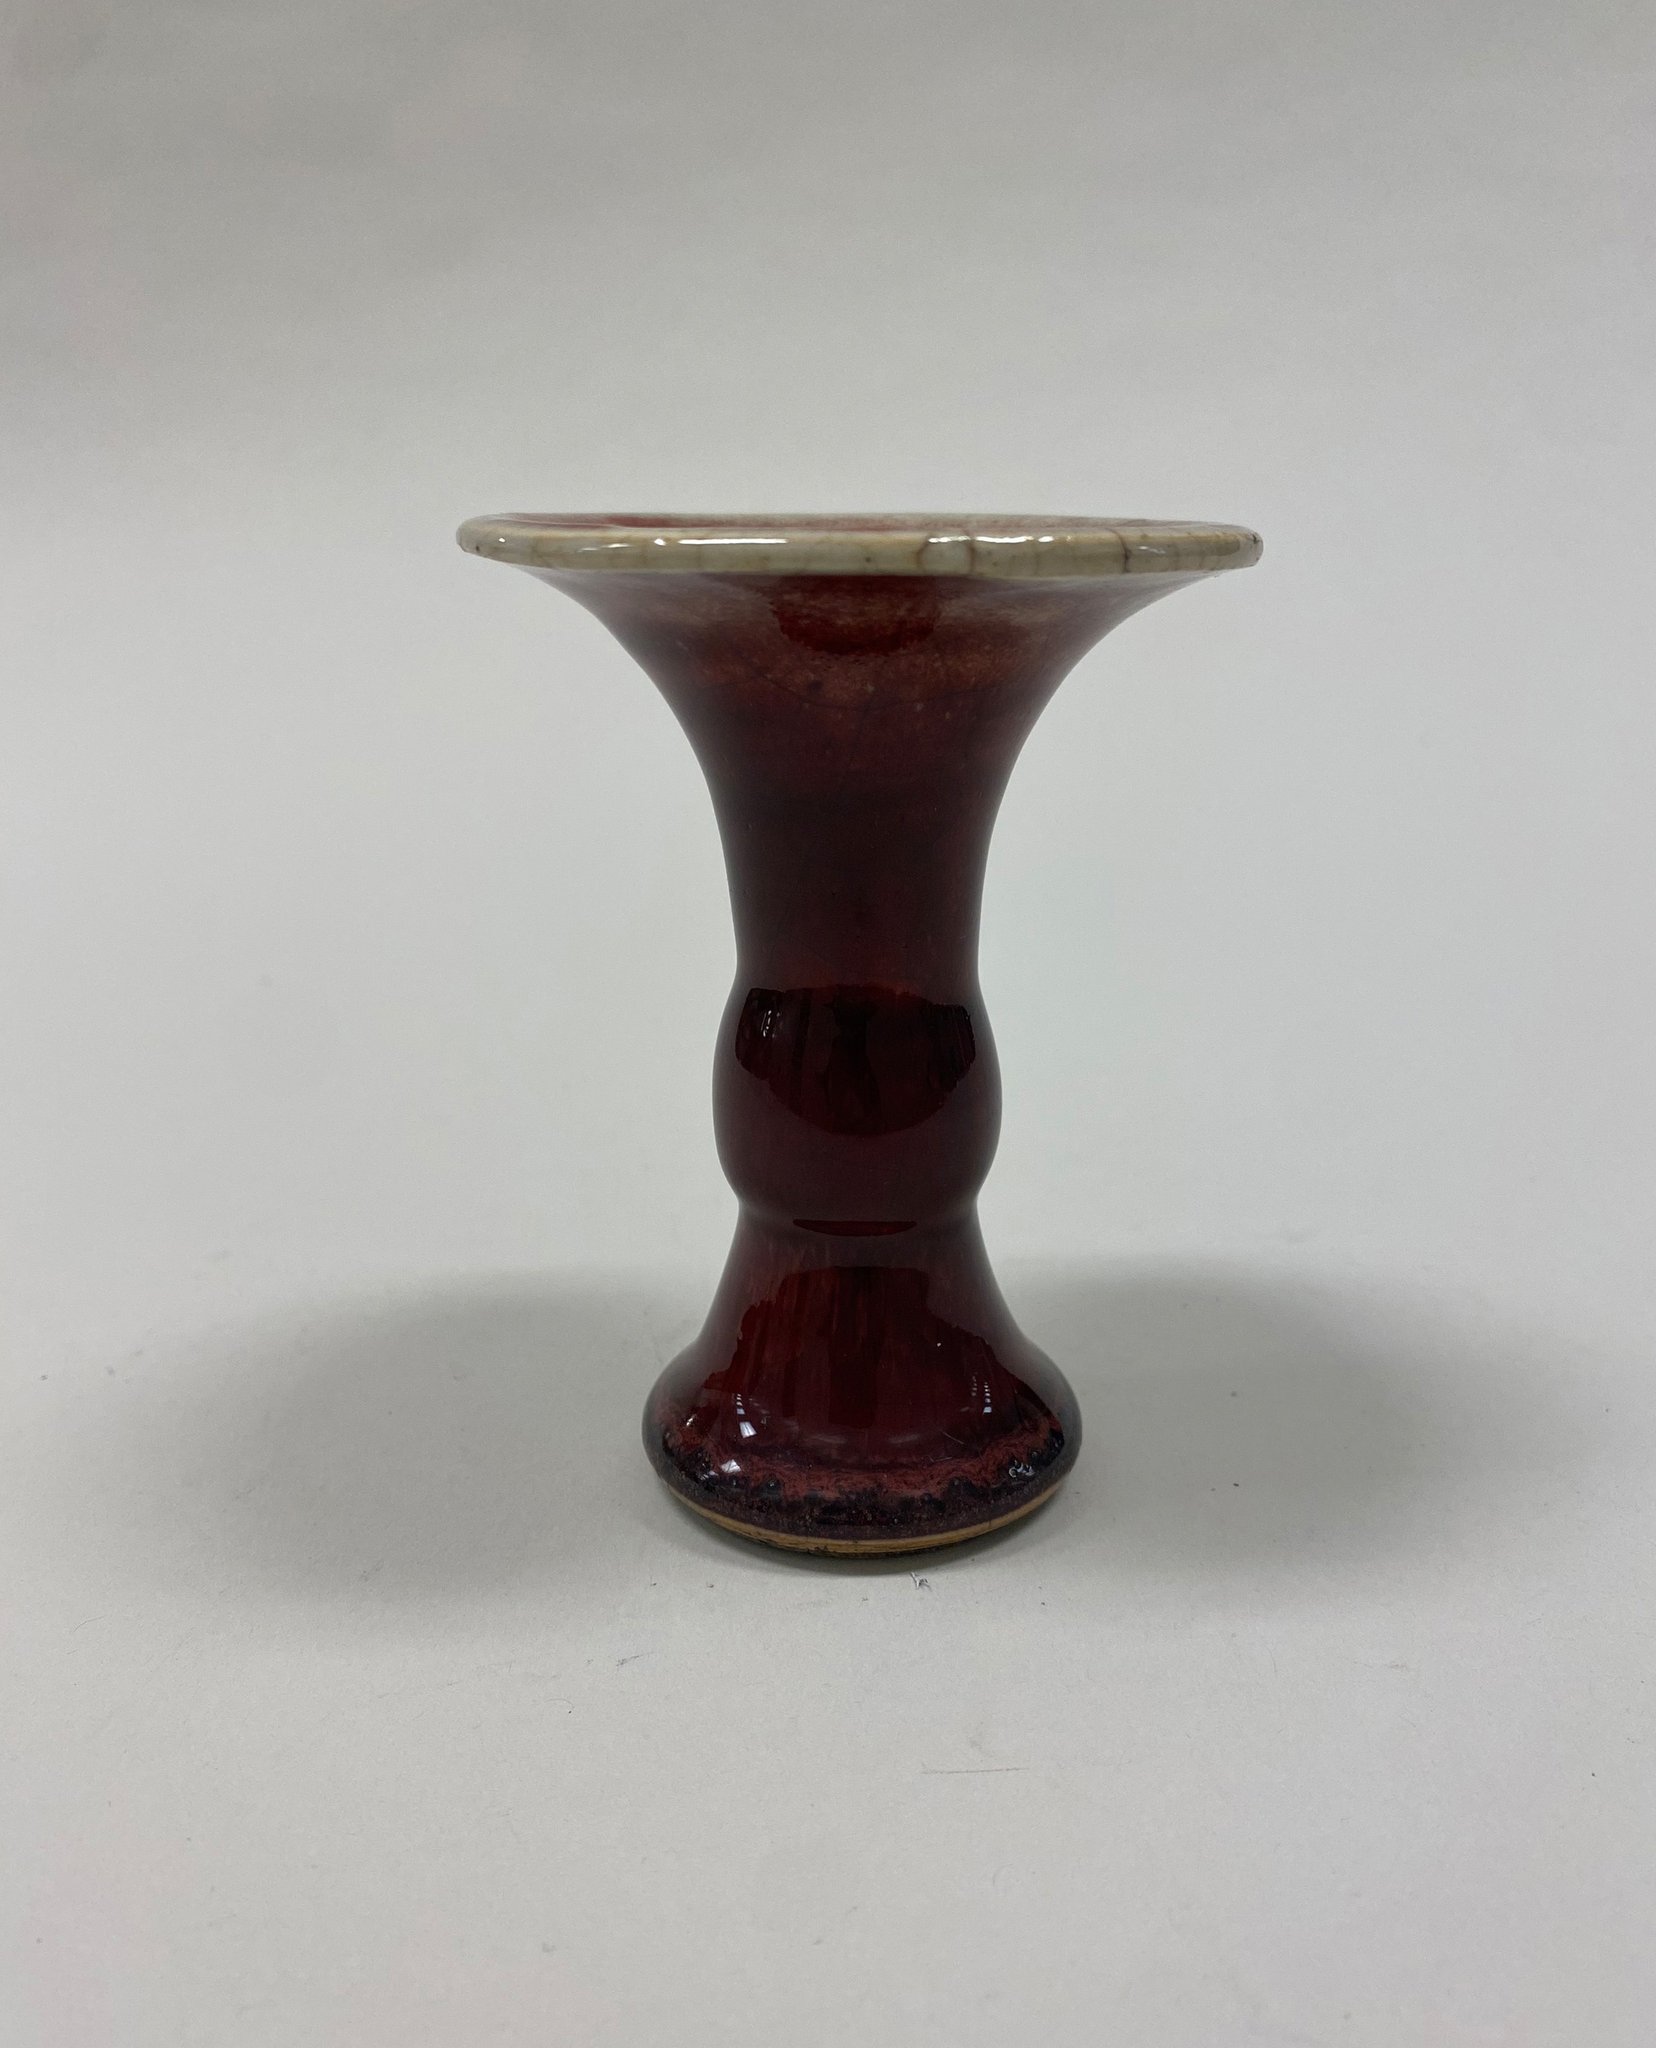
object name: vase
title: Miniature Vase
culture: chinese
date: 1701-1800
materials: copper, glaze, porcelain